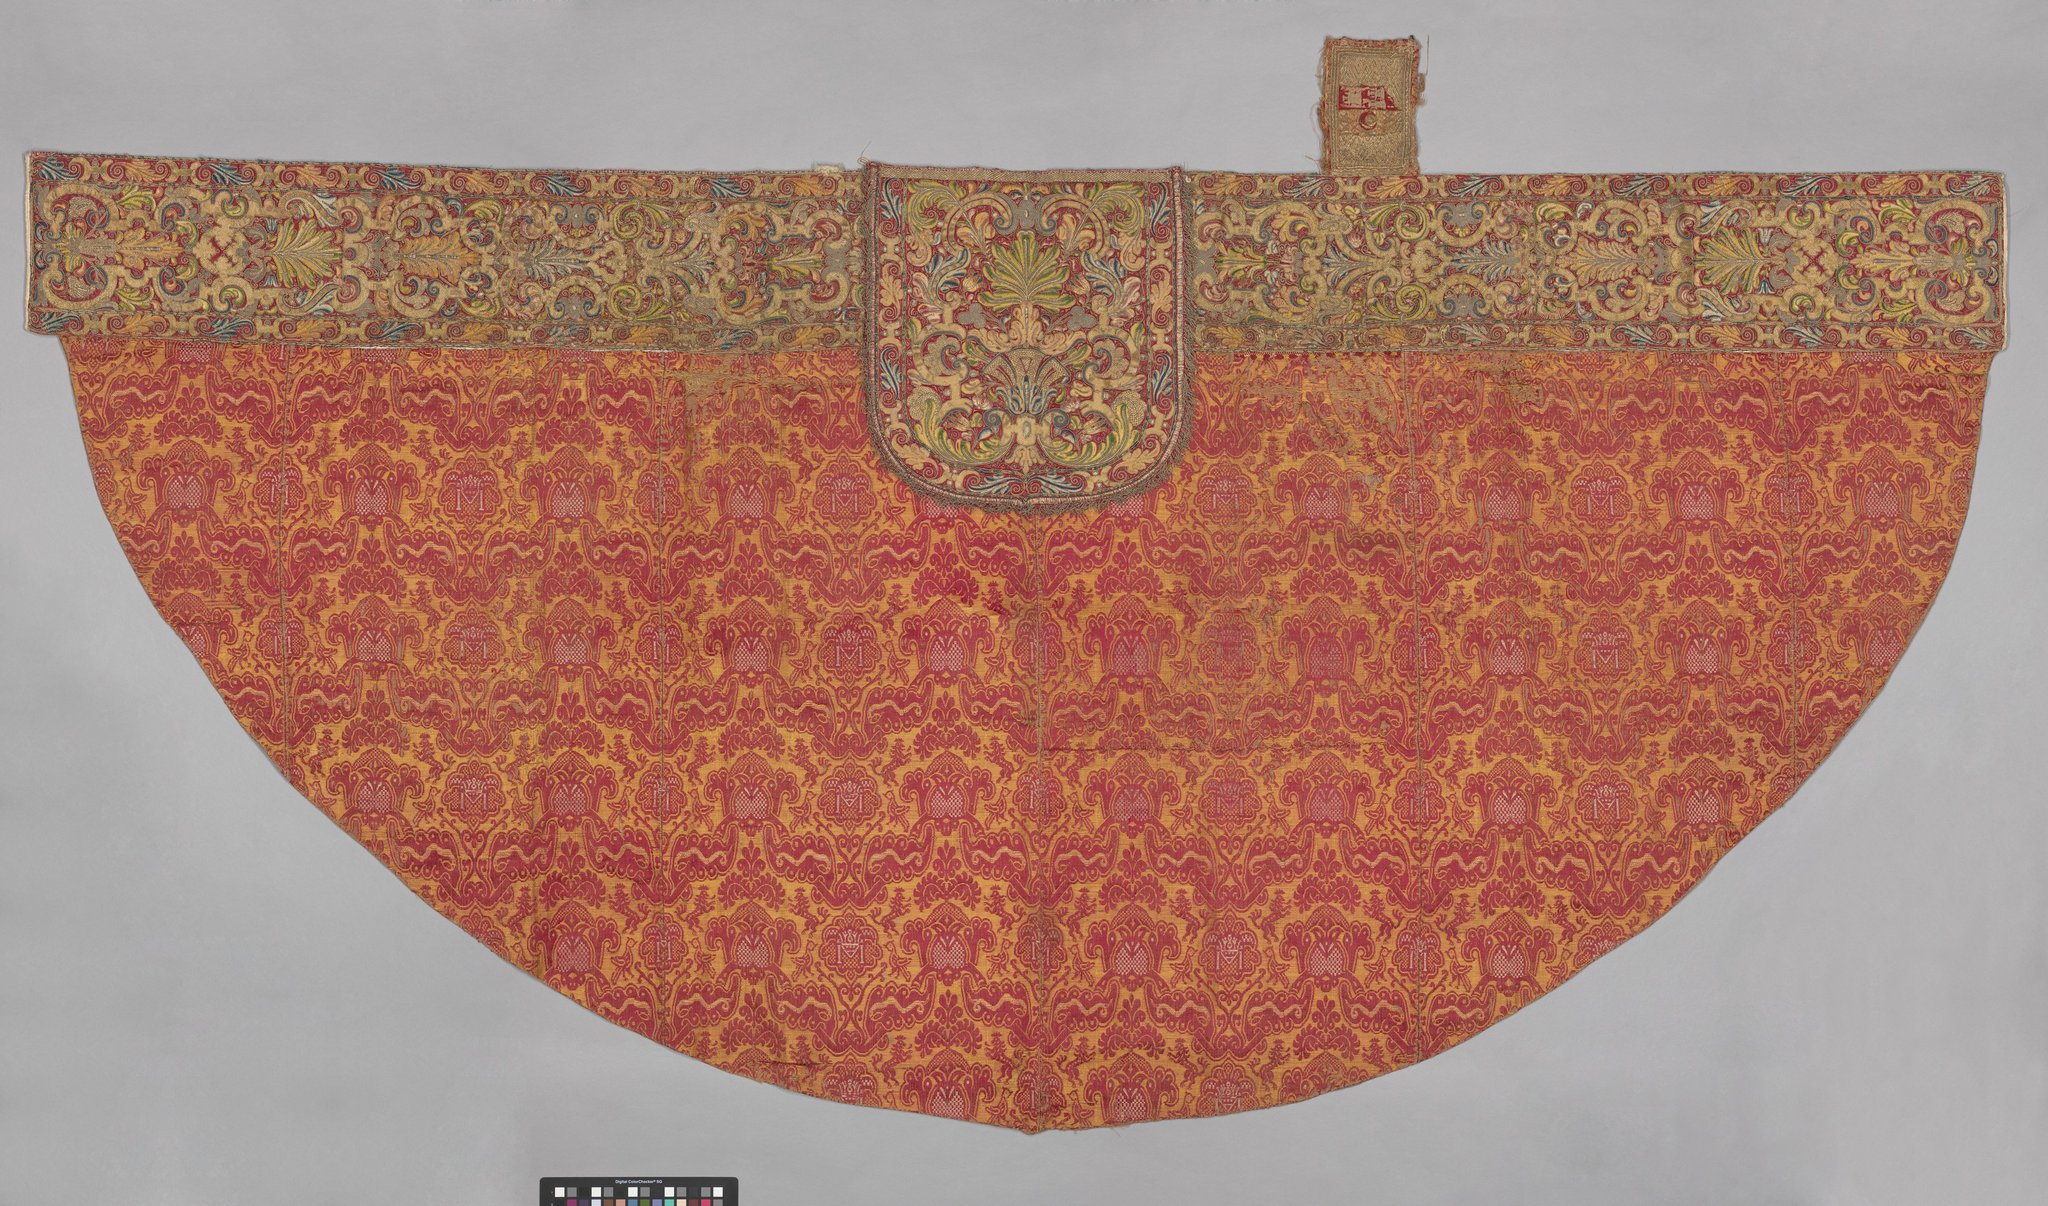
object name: cope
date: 1501-1600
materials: linen, metal thread, silk